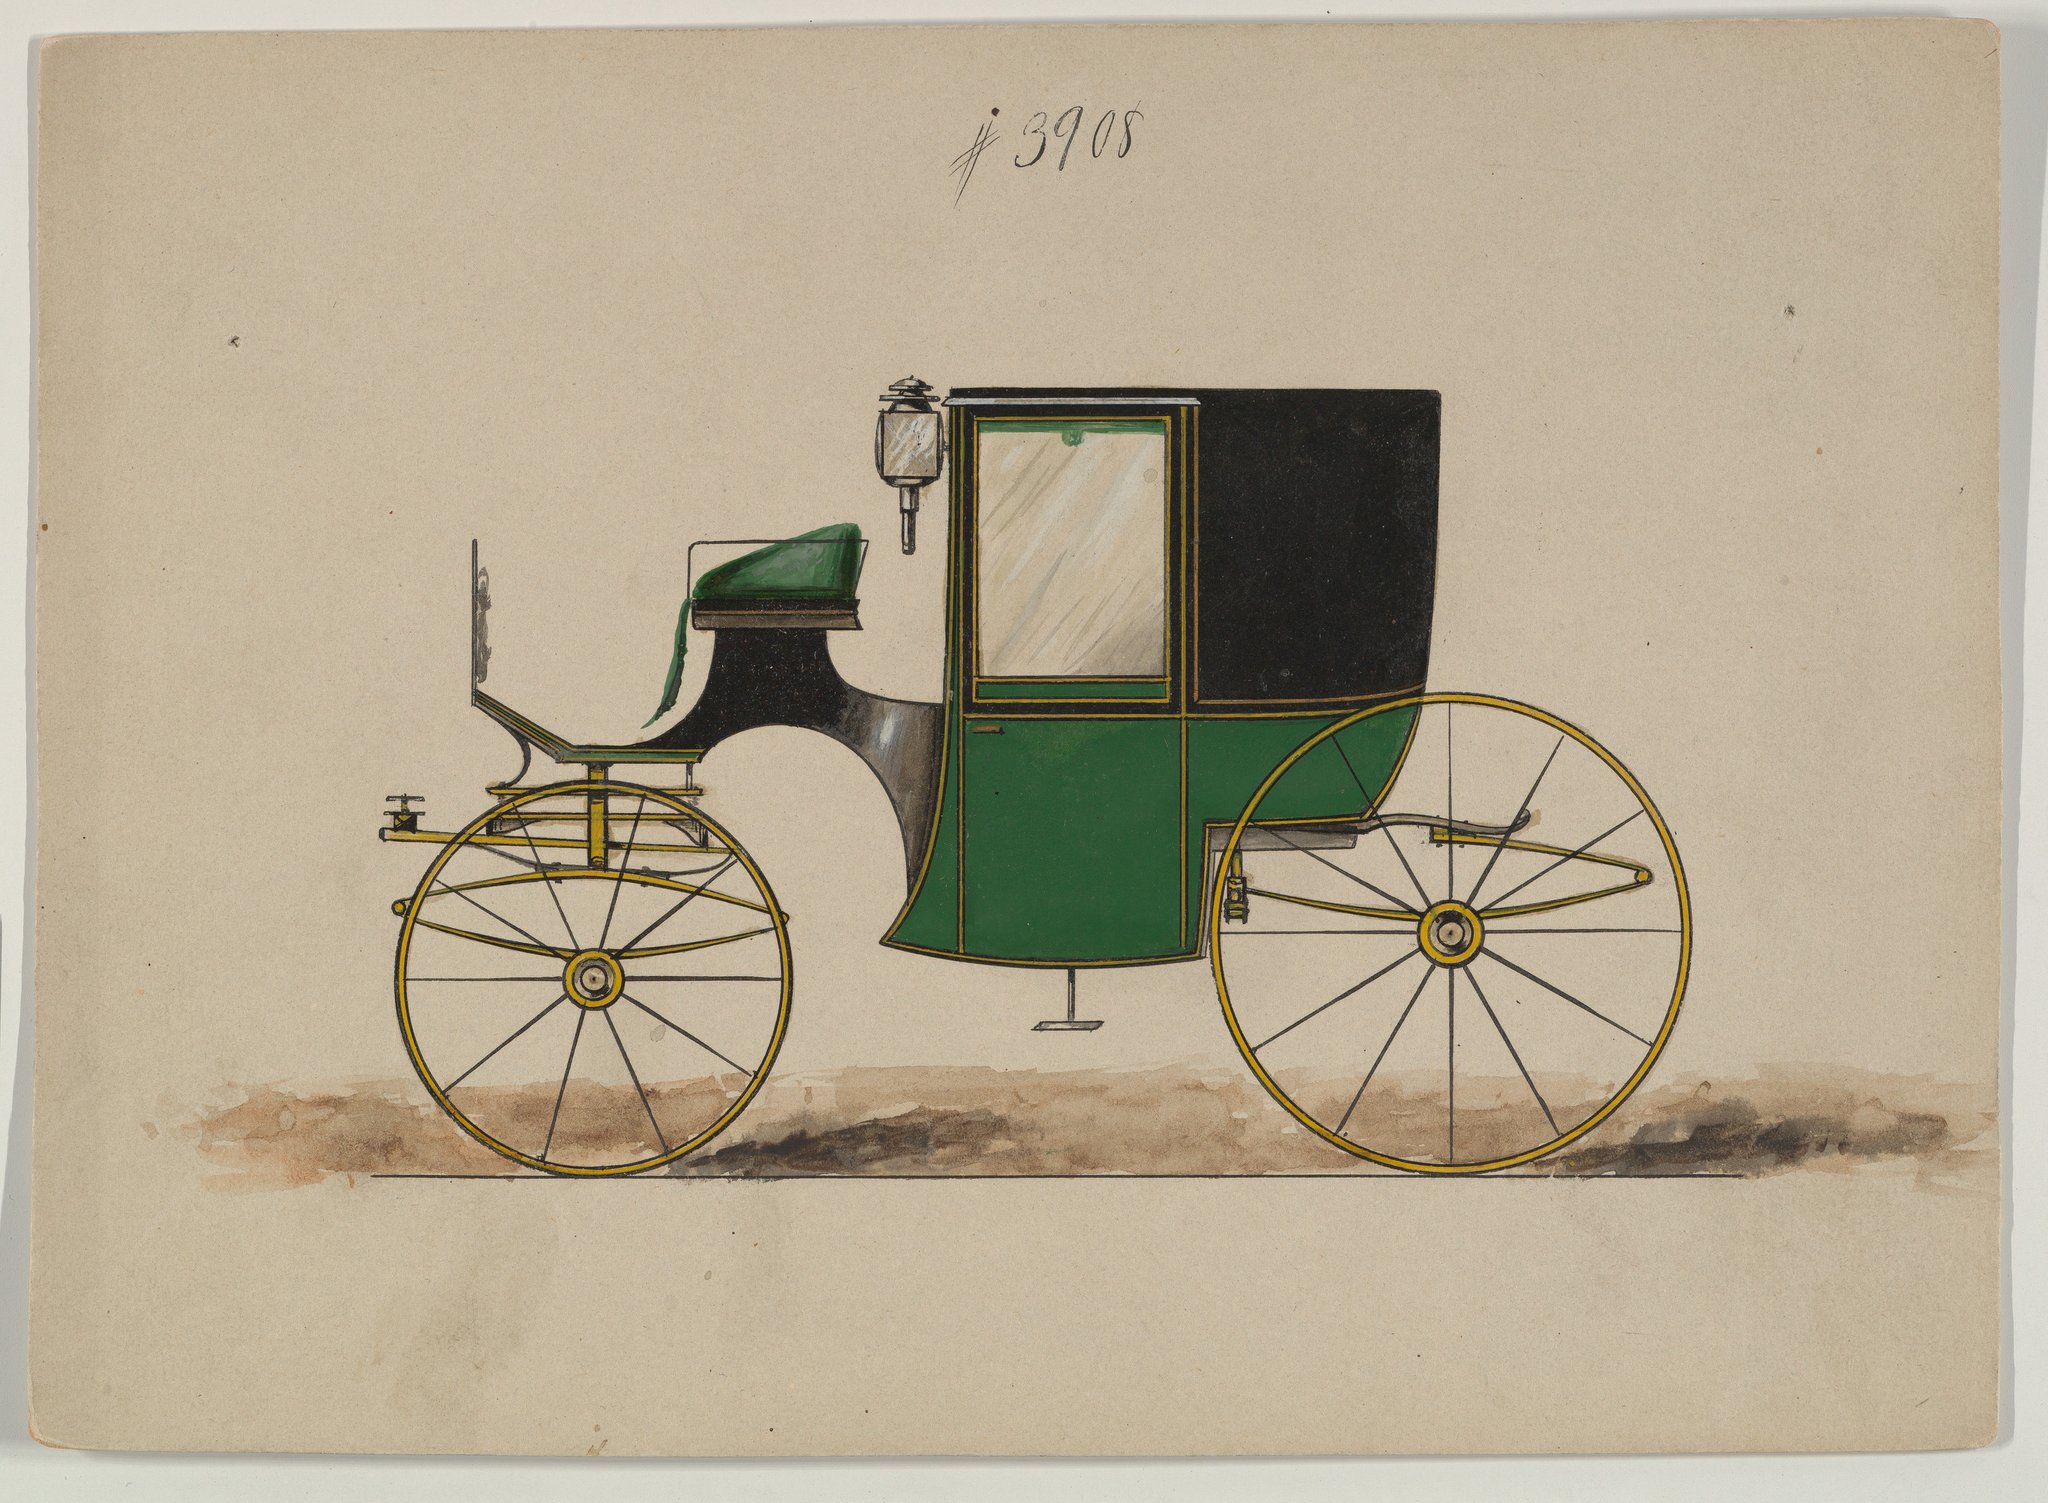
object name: drawing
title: Brougham #3908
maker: brewster & co.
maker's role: manufacturer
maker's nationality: american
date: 1884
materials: gouache, gum arabic, ink, watercolor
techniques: pen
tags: carriages